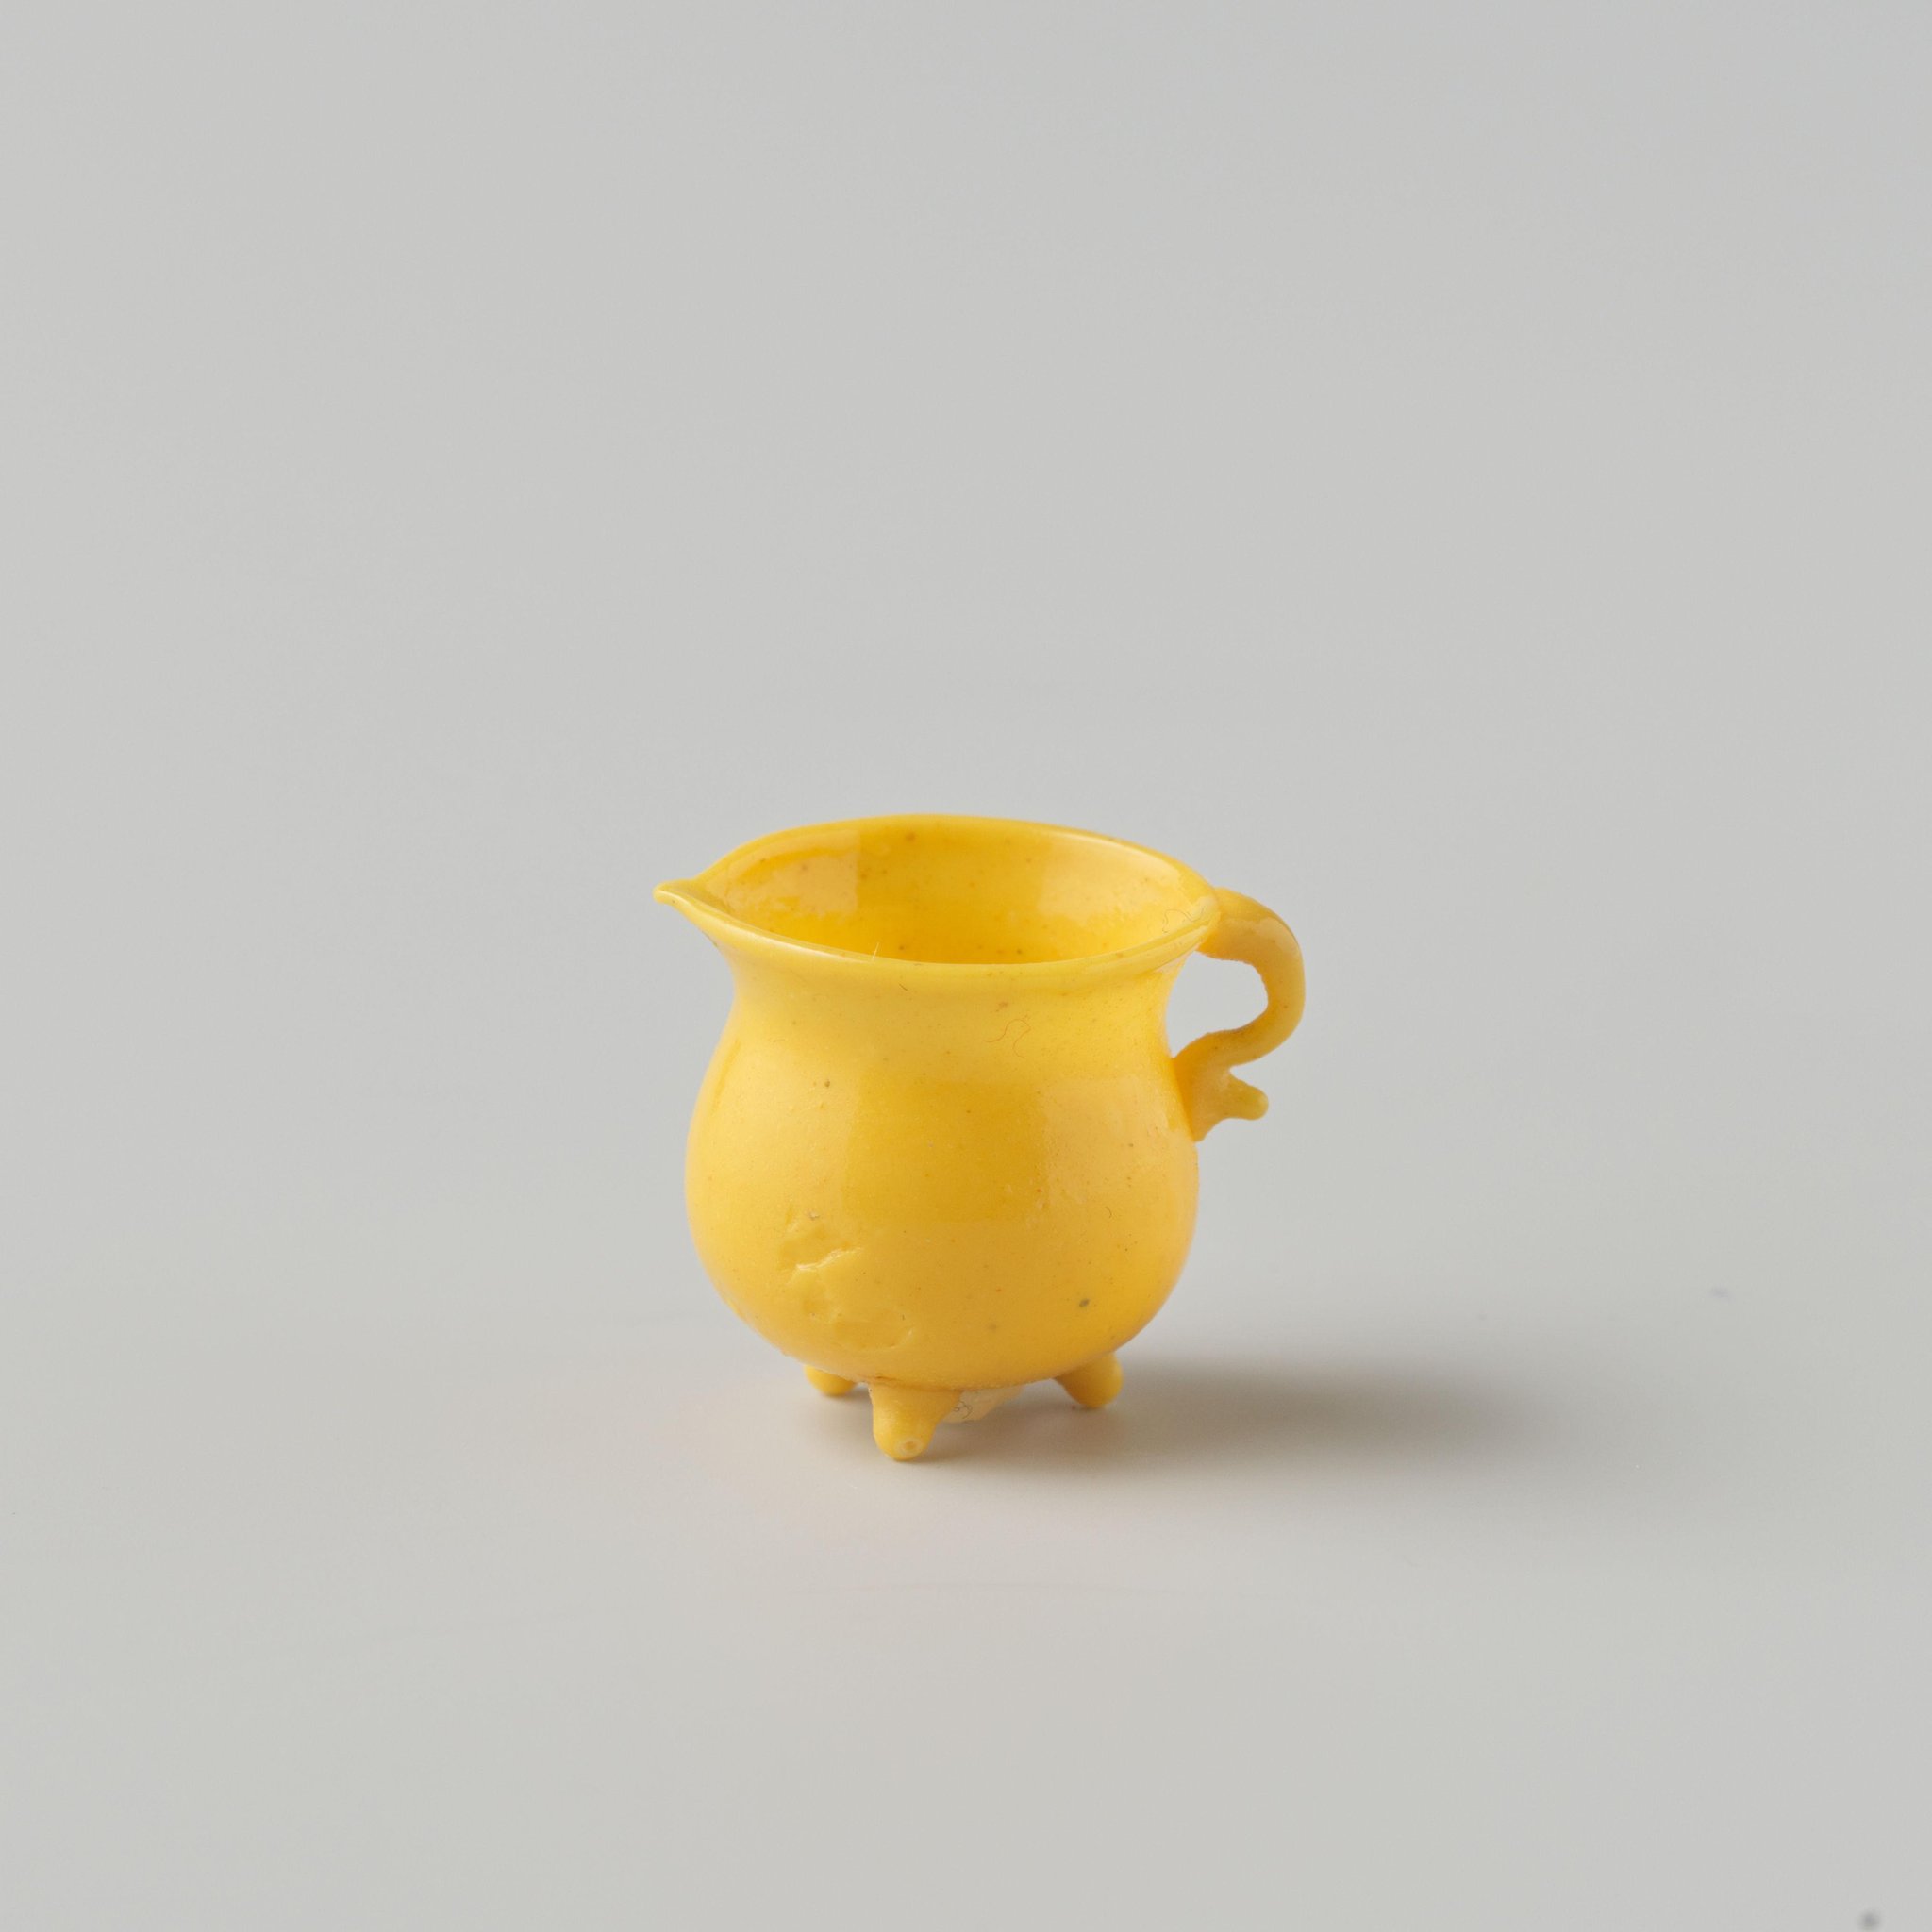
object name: kookkan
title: Kookkan van opaak geel glas (waarschijnlijk imitatie geel aardewerk); op drie pootjes met schenklip en oor.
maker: Anonymous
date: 1675-1710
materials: glass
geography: amsterdam